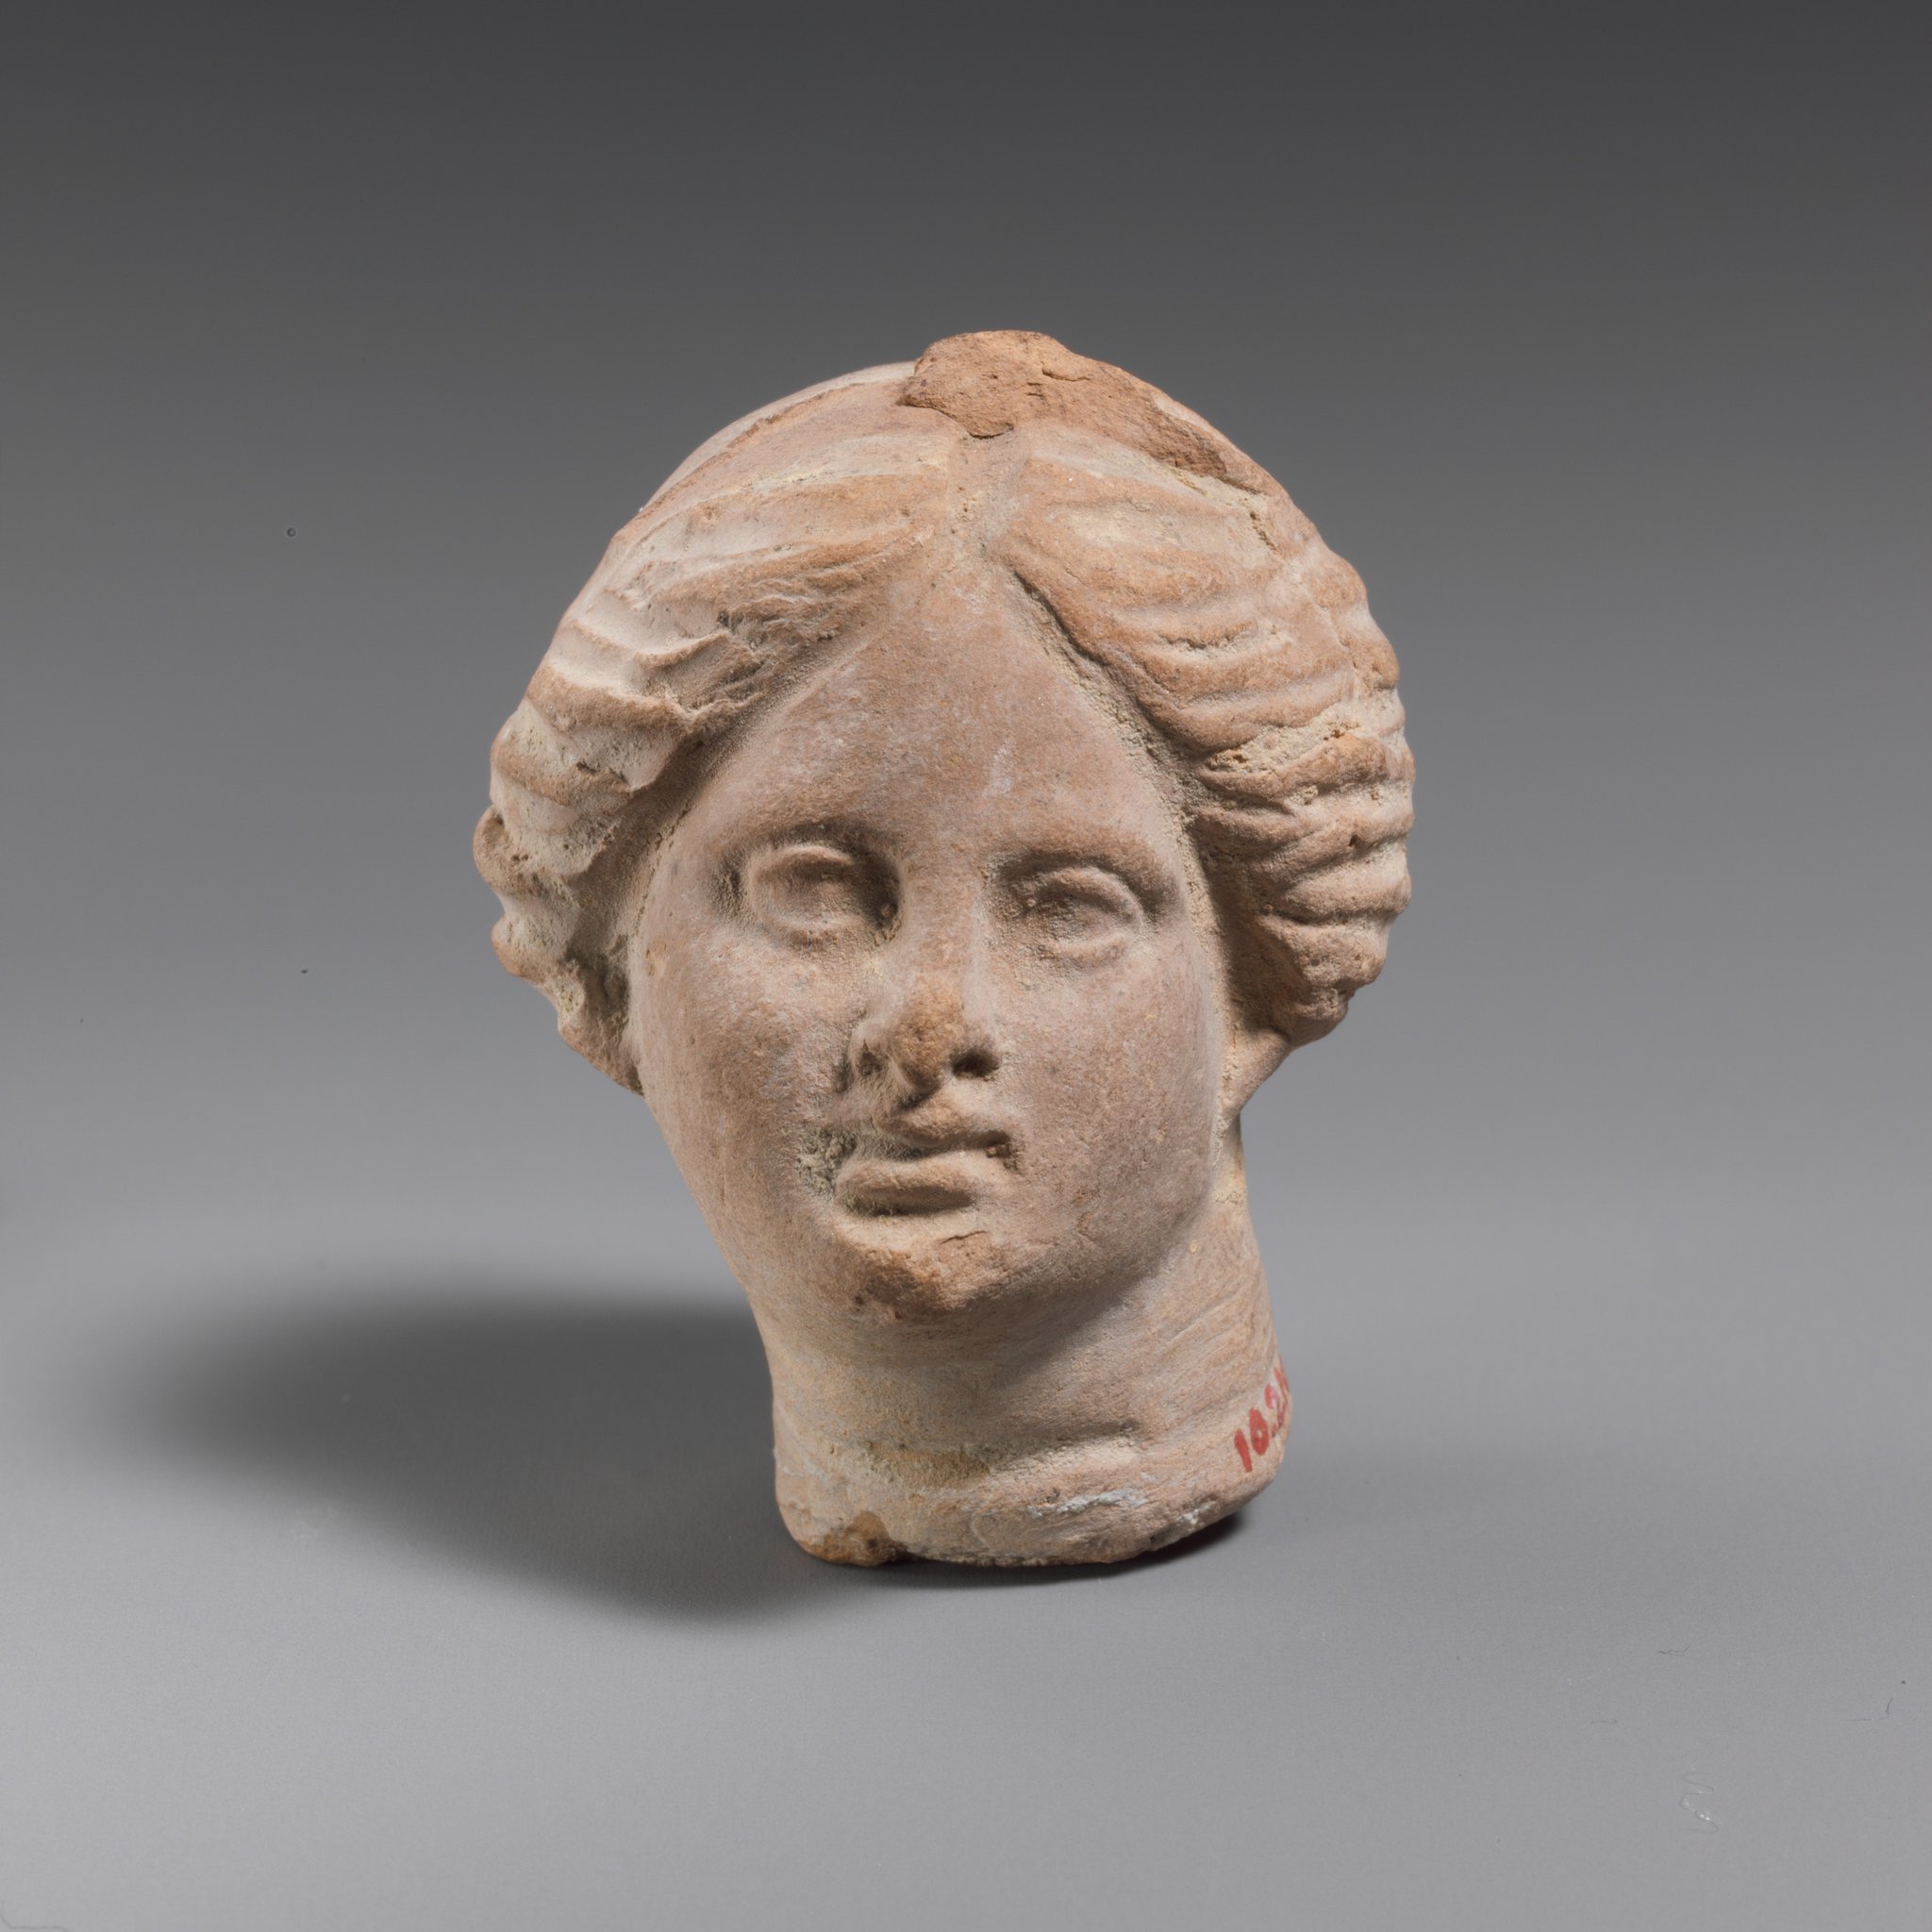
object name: head of a woman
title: Terracotta female head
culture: greek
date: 300-101 BCE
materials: terracotta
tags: heads,women